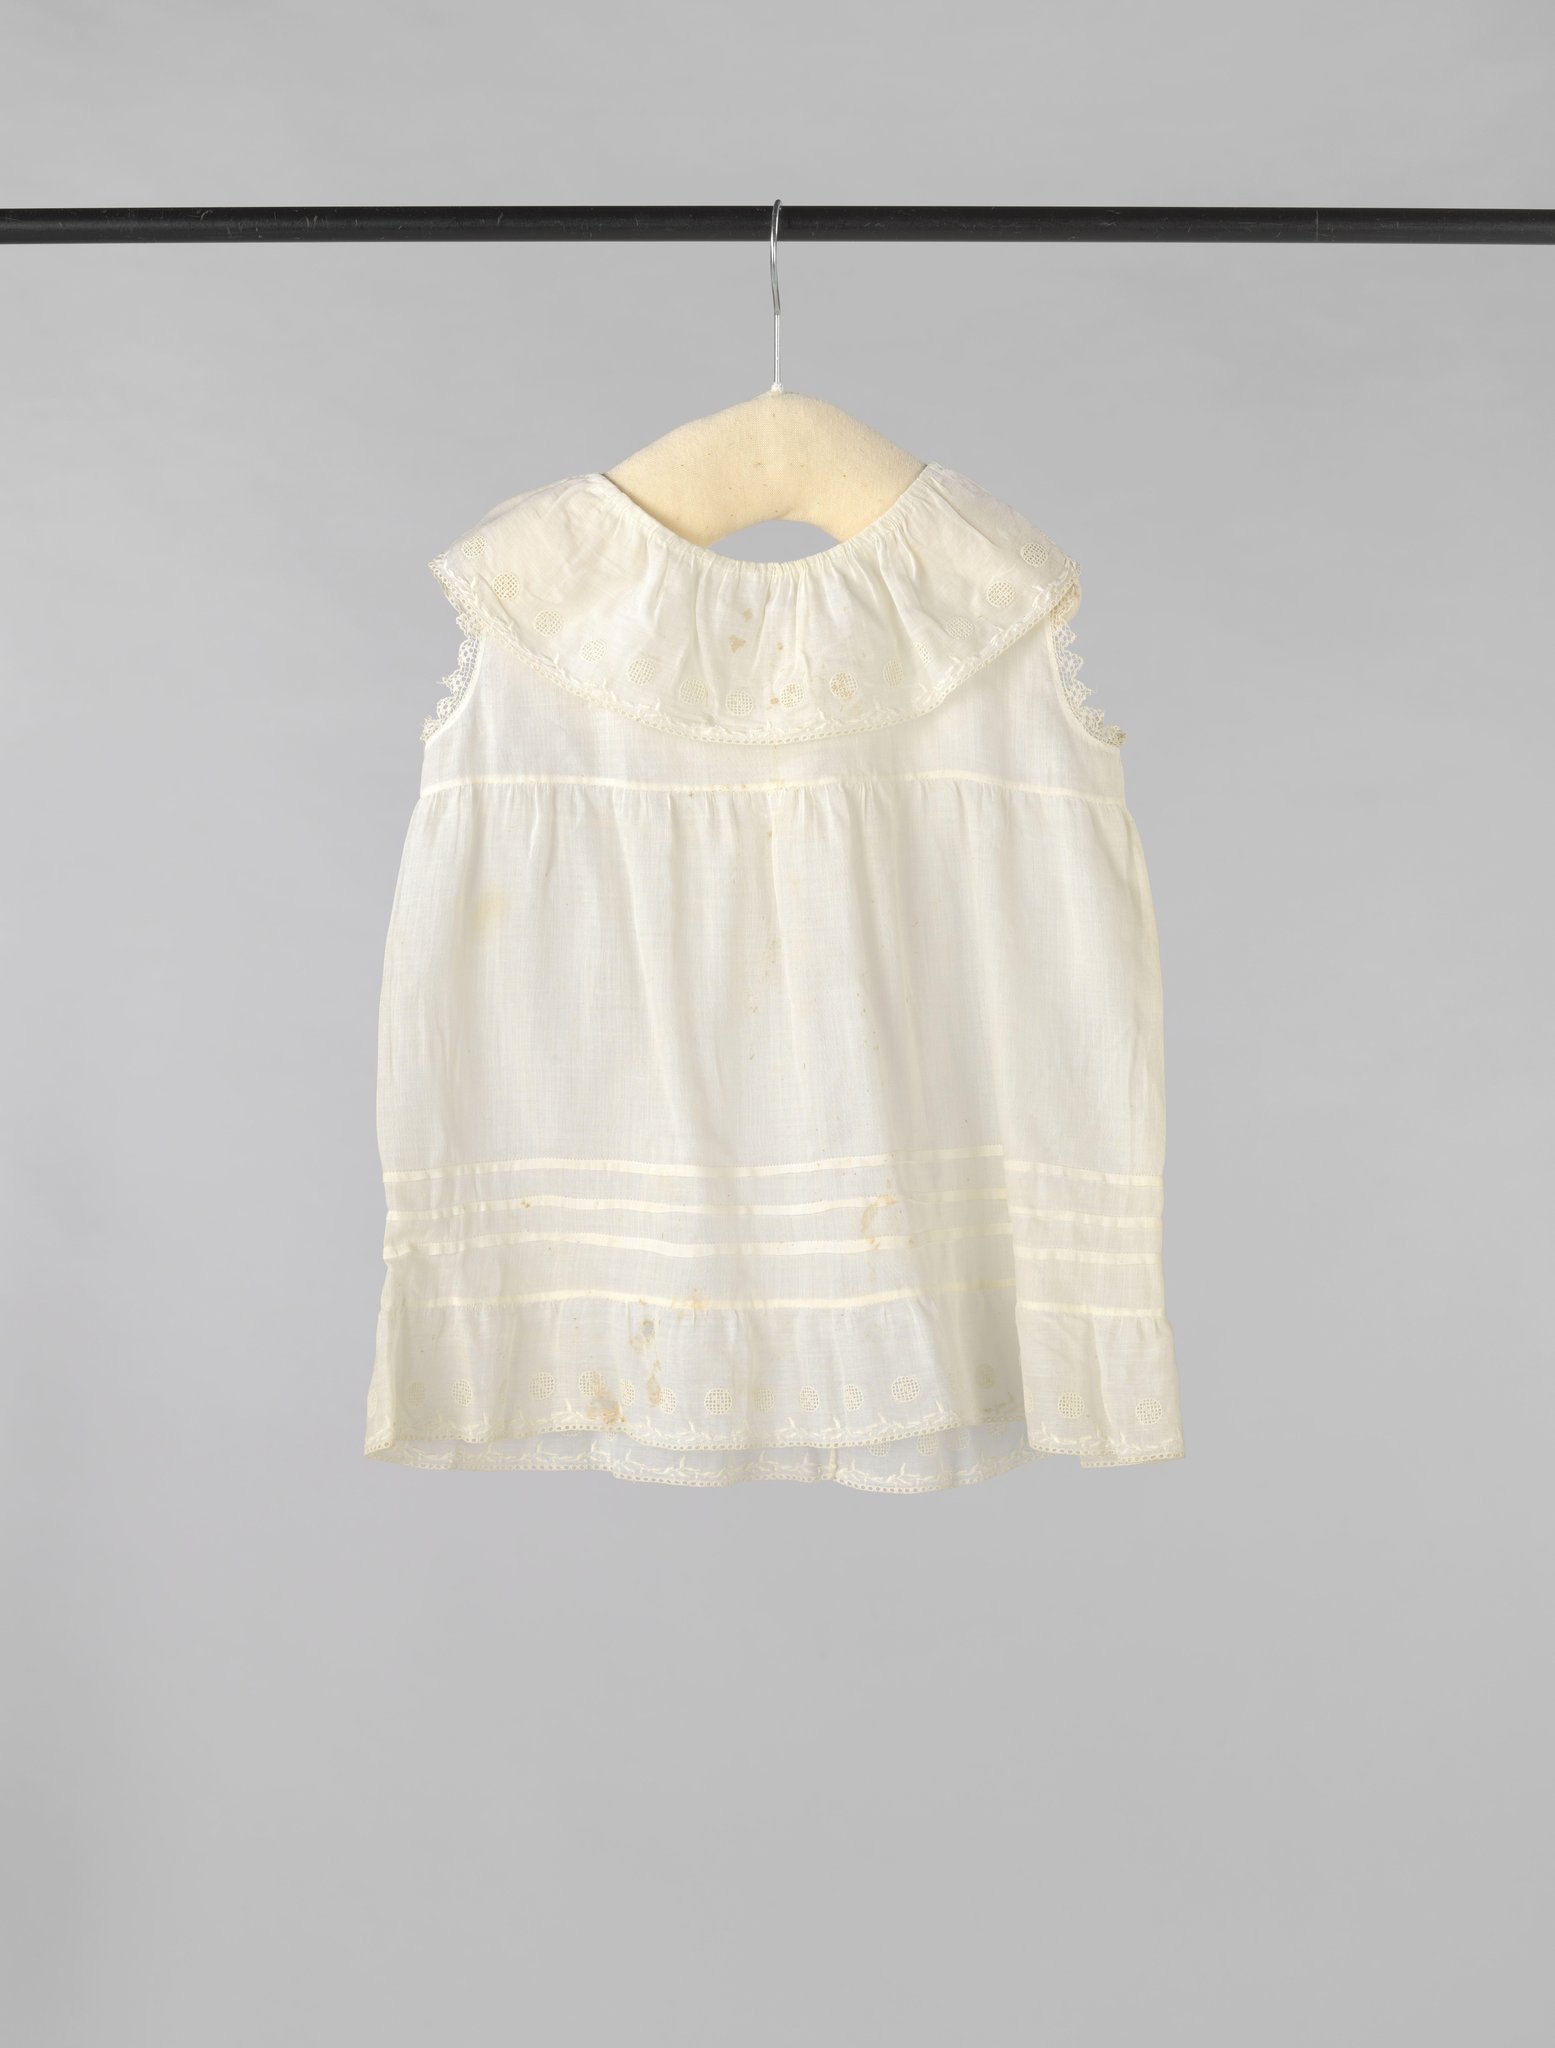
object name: main garment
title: Mouwloze kinderjurk van wit batist, op de kraag en rok versierd met wit borduurwerk en op de rok ook nog drie oprijgen bij de zoom; langs armsgaten gehaakte rand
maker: Anonymous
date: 1922-1926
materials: textile, cotton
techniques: crochet, embroidered, embroidery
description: Mouwloze kinderjurk van wit batist, op de kraag en rok versierd met wit borduurwerk en op de rok ook nog drie oprijgen bij de zoom; langs armsgaten gehaakte rand.